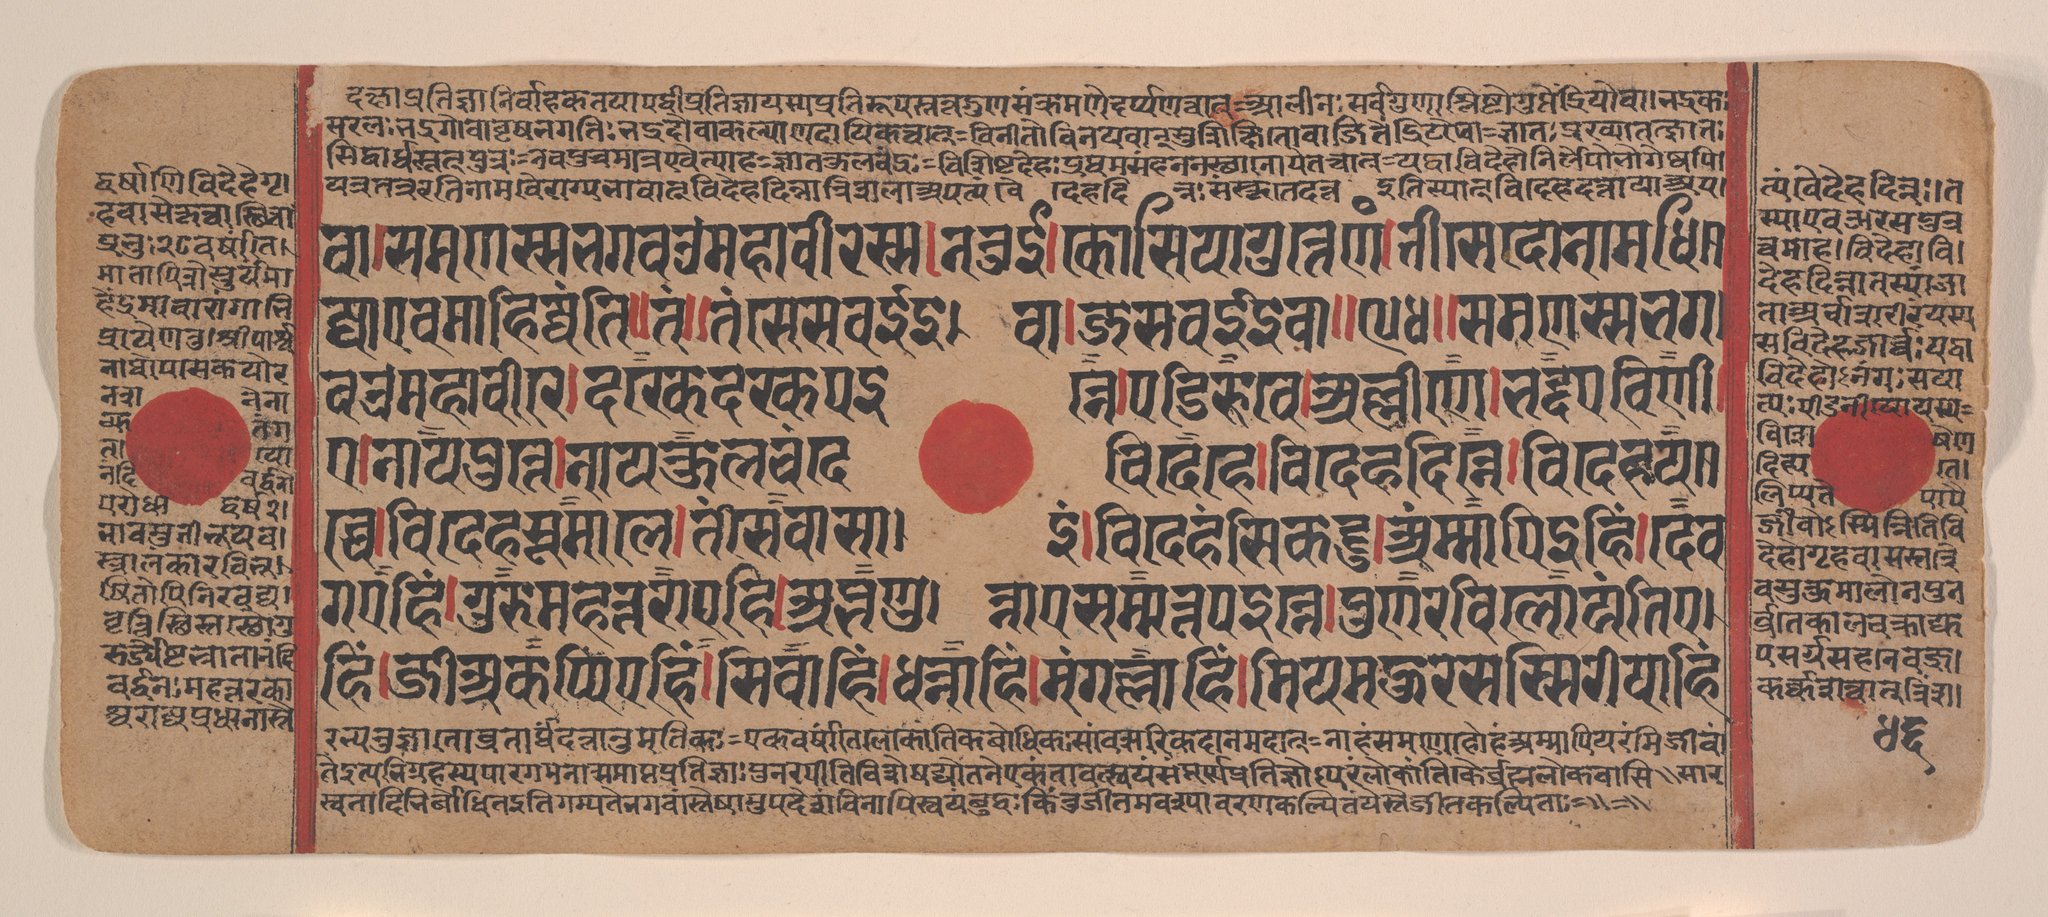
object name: folio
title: Page from a Dispersed Kalpa Sutra (Jain Book of Rituals)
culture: indian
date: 1401-1500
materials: gold, ink, paper, watercolor